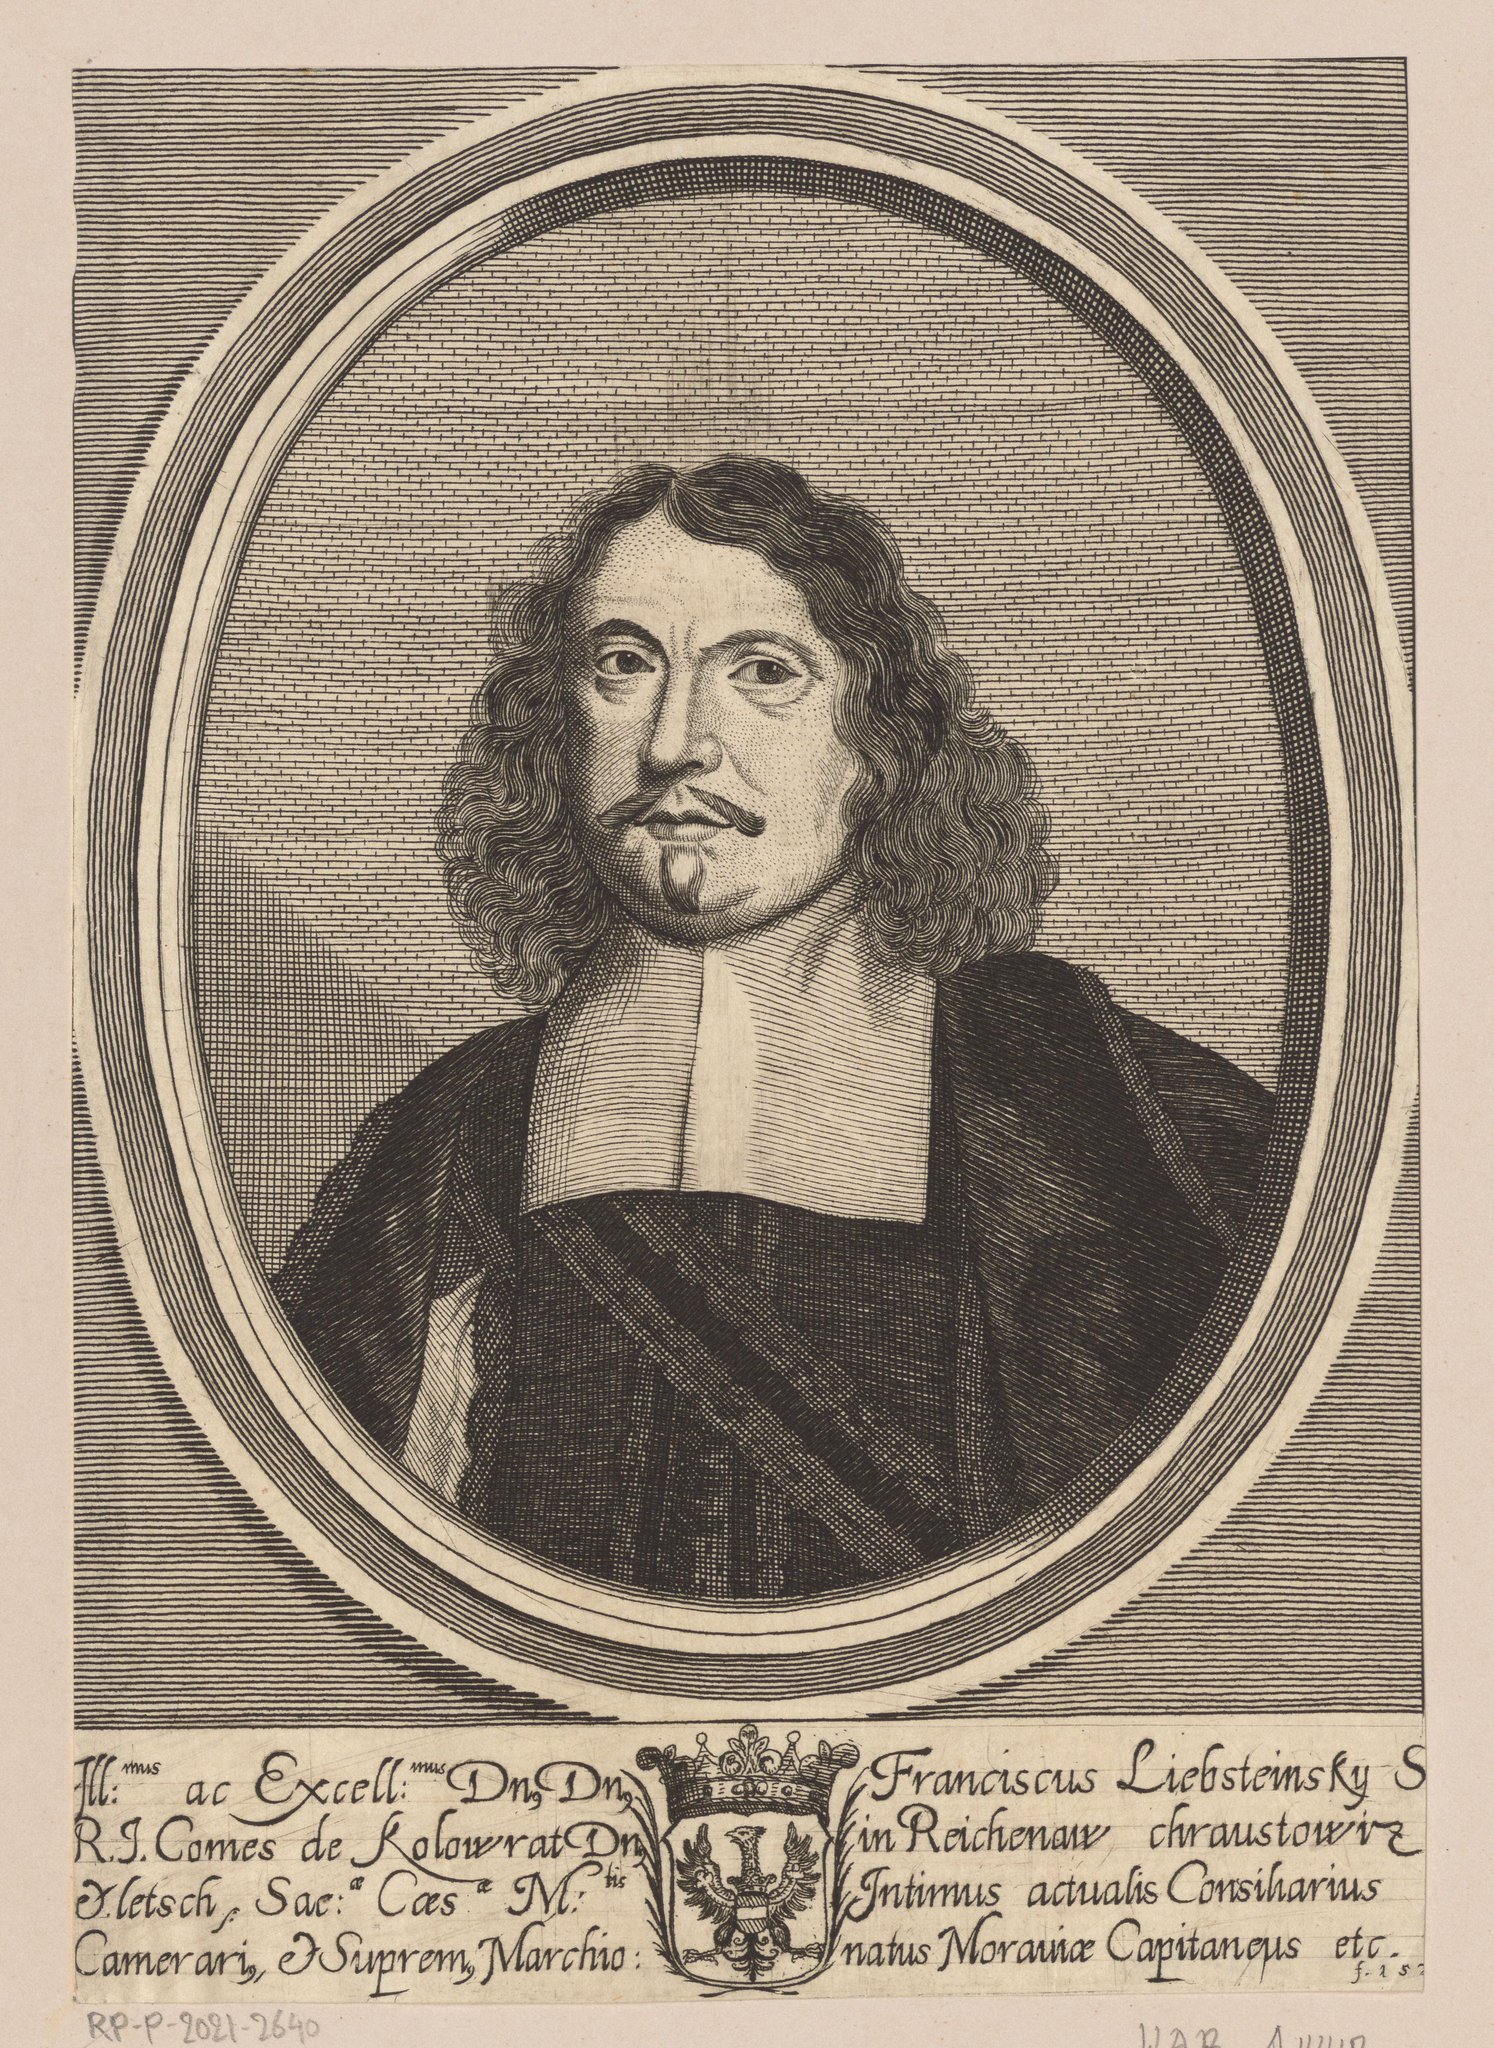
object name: print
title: Portret van Franz Karl graaf van Kolowrat-Liebsteinsky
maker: Anonymous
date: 1640-1749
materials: paper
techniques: engraving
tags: historical persons, armorial bearing, heraldry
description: Onder het portret zijn wapenschild. Rechtsonder genummerd: f. 157.